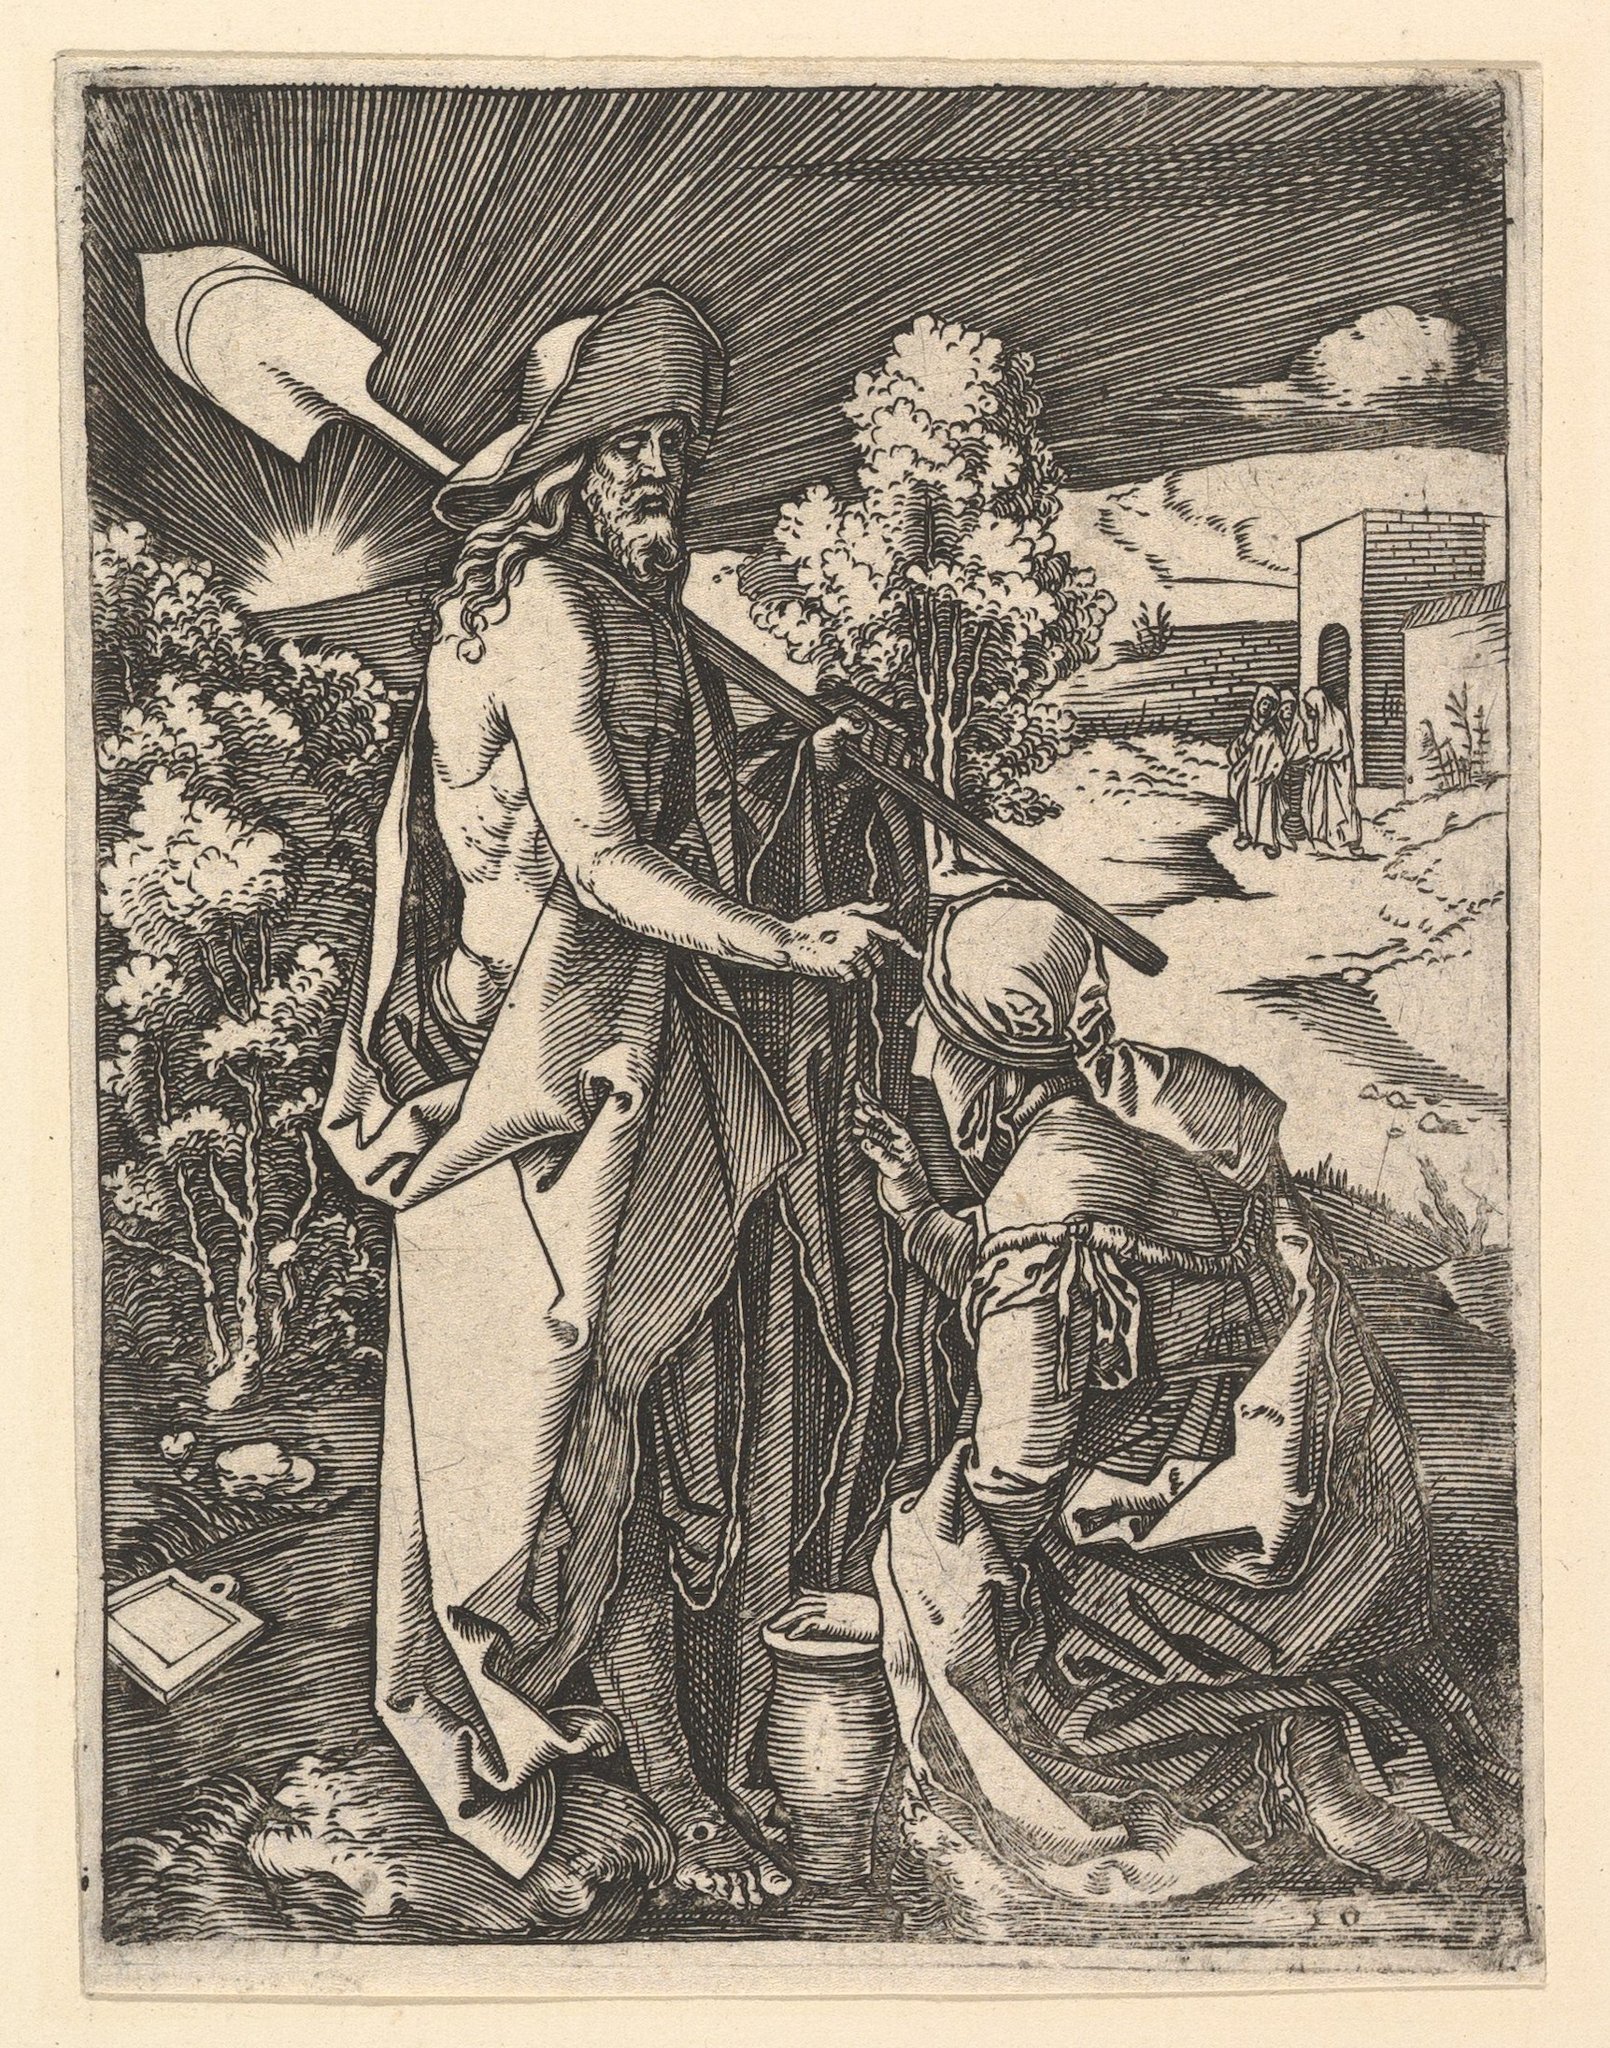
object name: print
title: Christ Appearing to the Magdalen as a gardener, from "The Passion of Christ", after Dürer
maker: marcantonio raimondi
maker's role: artist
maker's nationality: italian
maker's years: 1475-1534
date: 1500-1534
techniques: engraving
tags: plants,christ,mary magdalene,gardeners